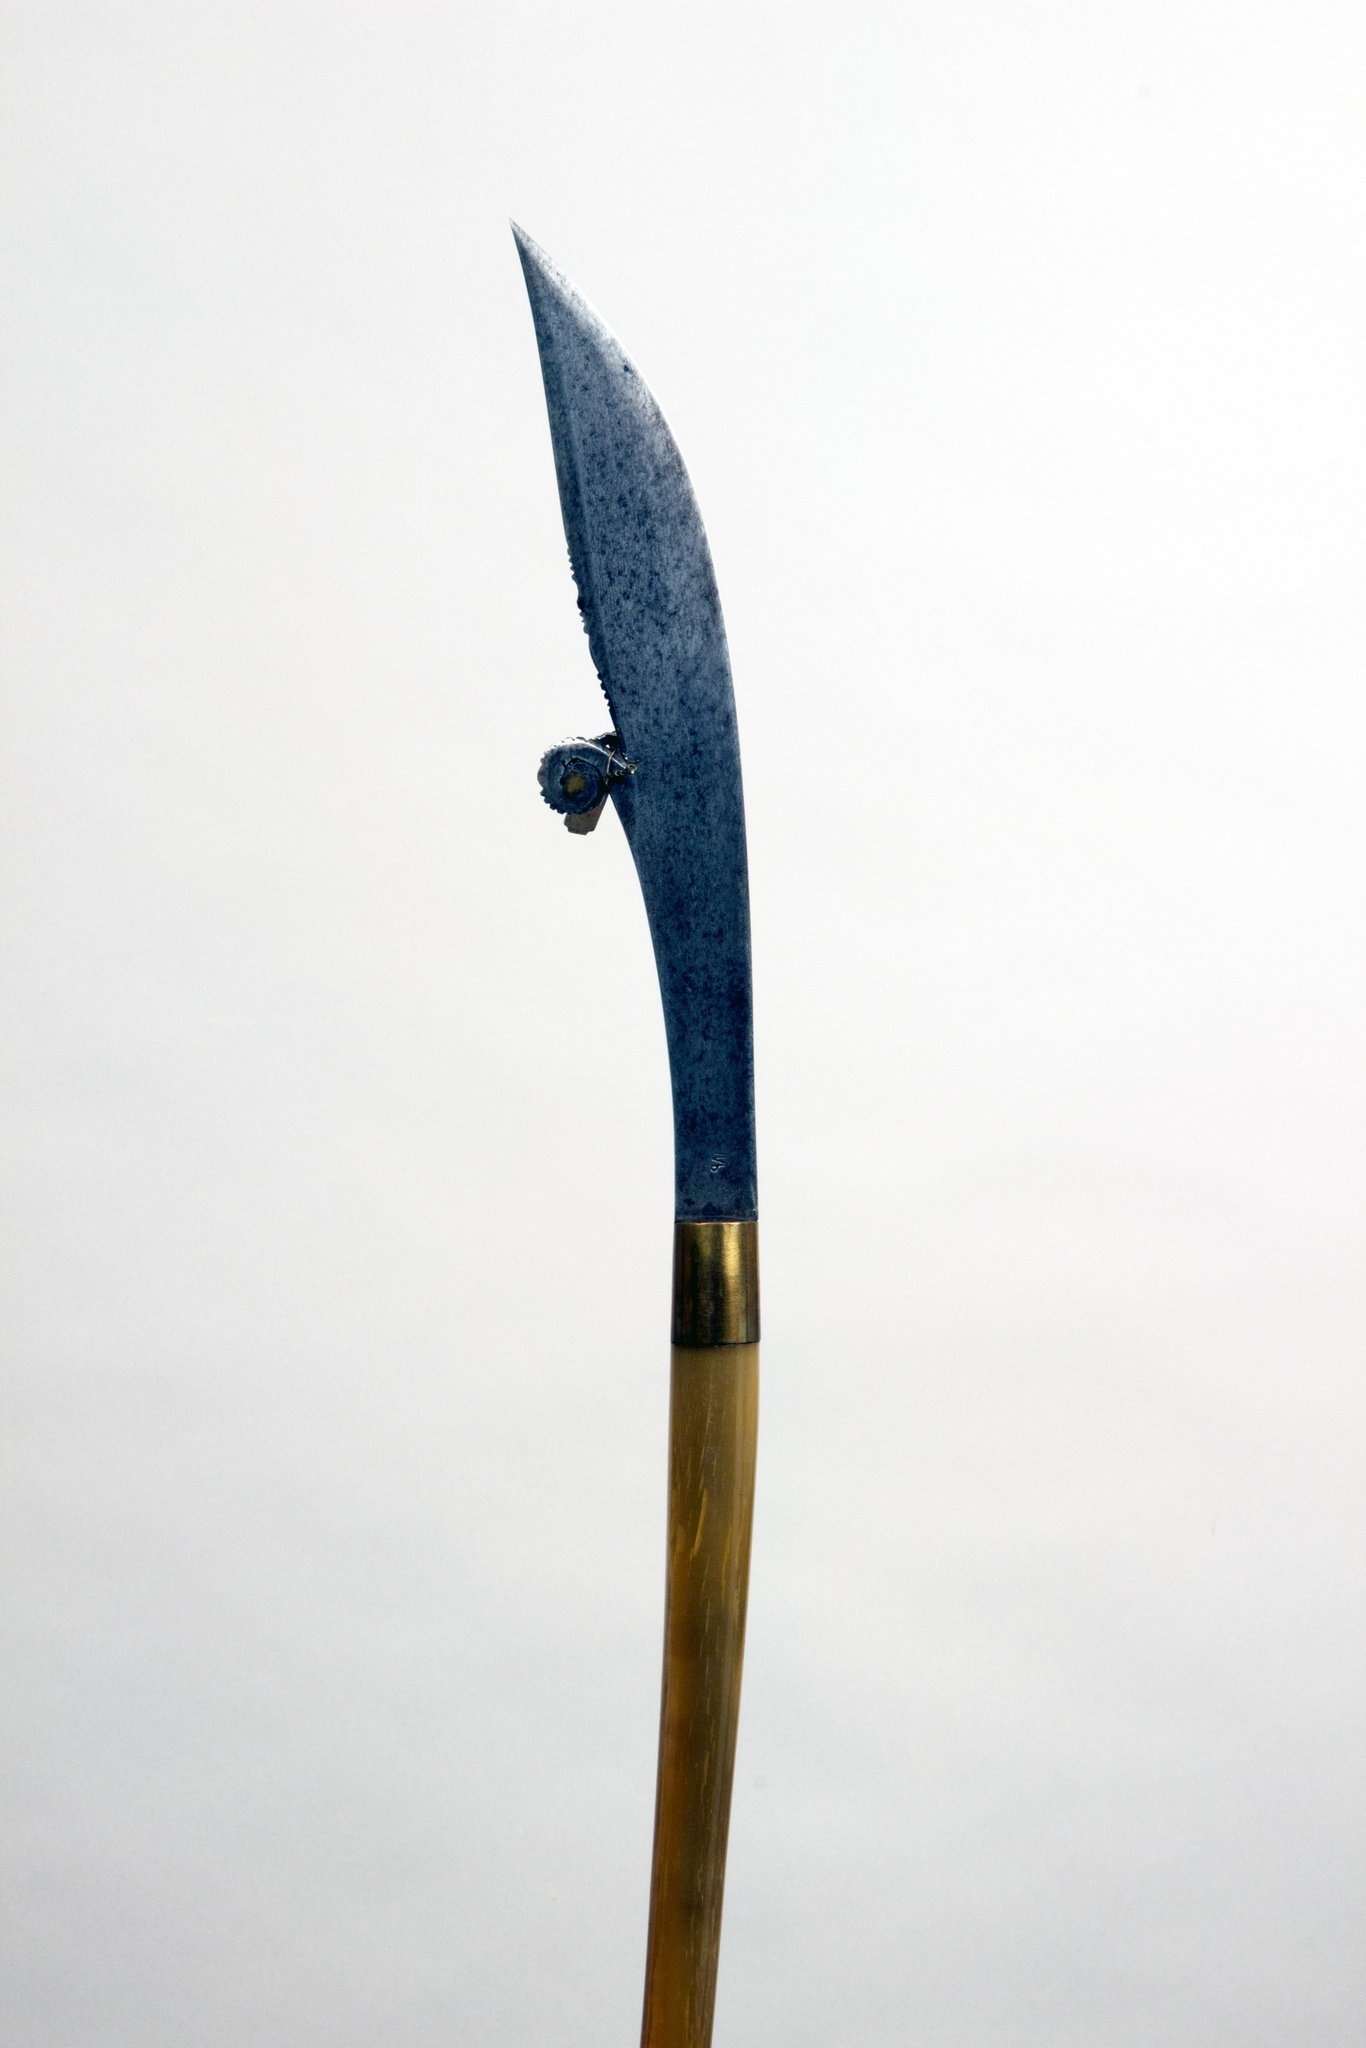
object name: knife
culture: thai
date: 1701-1900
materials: brass, horn, rattan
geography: thailand